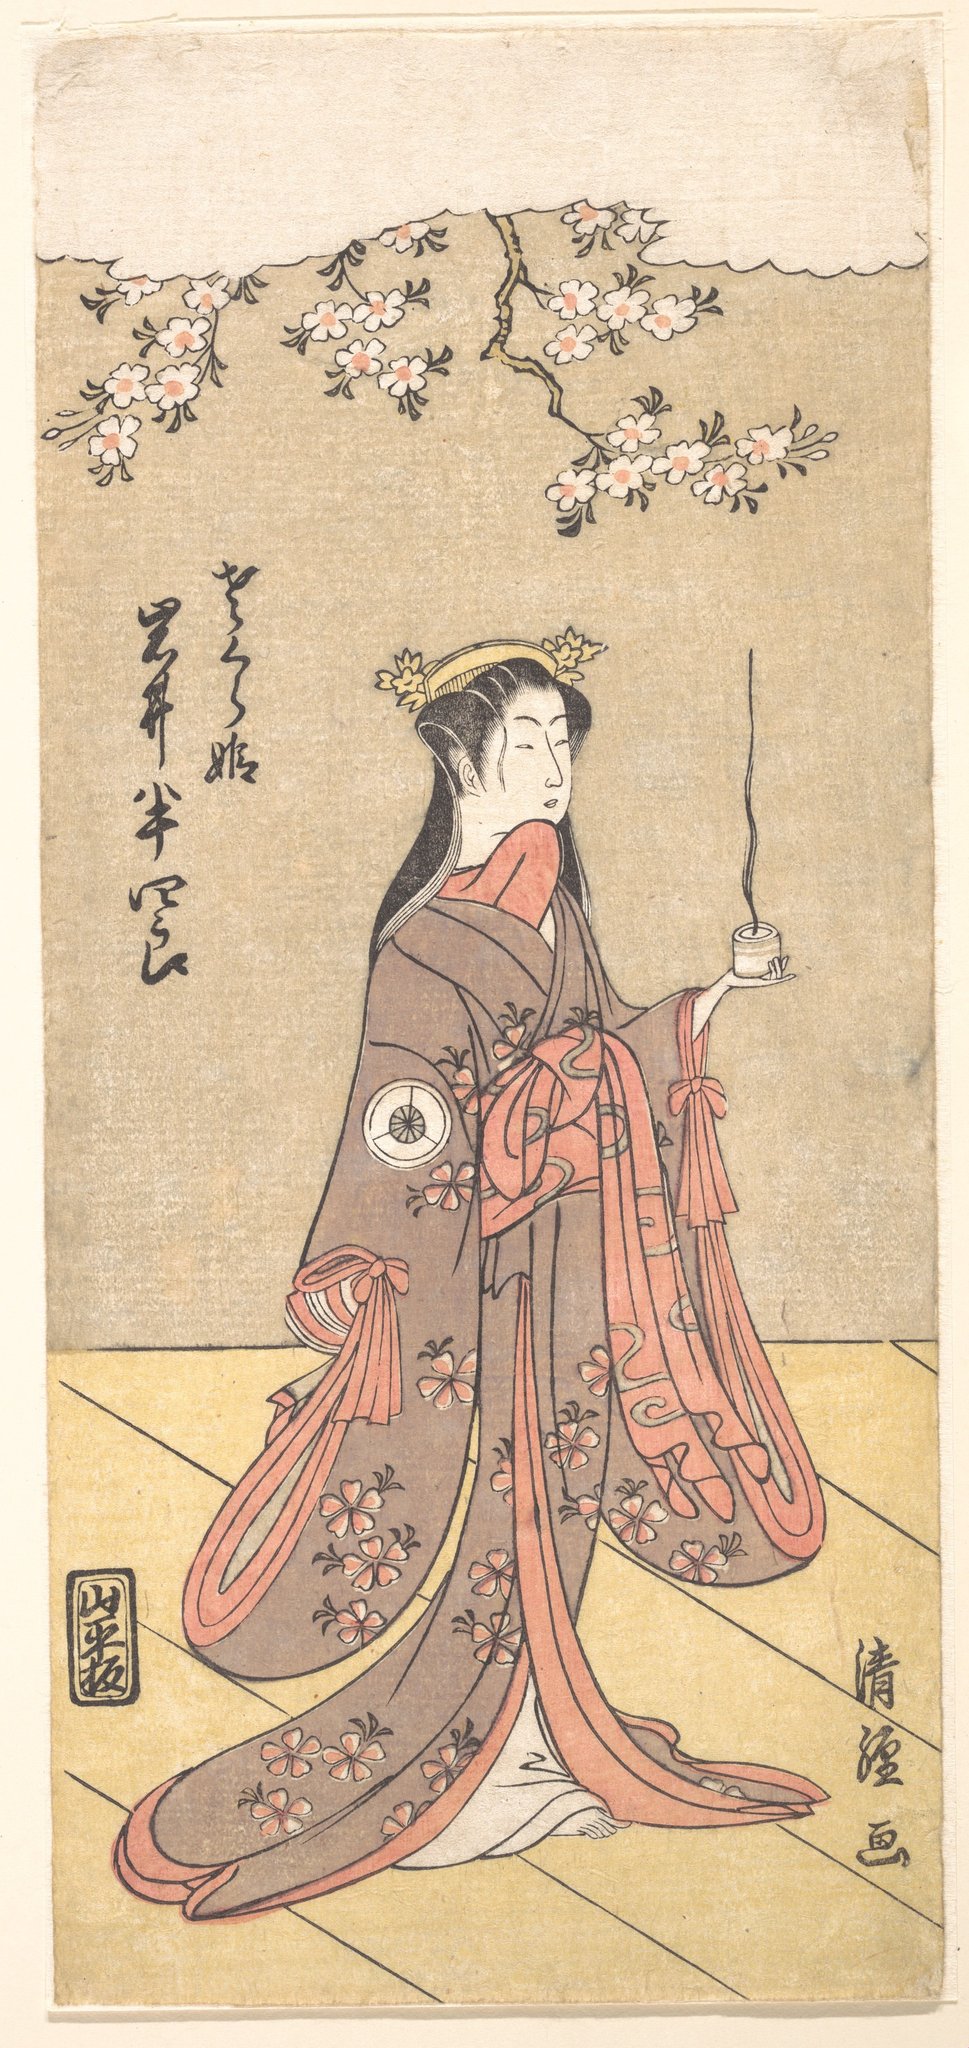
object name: print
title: The Actor Iwai Hanshirō IV as Sakura Hime, the Cherry Princess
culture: japanese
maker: torii kiyotsune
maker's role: artist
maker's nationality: japanese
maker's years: 1757-1779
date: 1767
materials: ink, paper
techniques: woodblock print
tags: women,actors